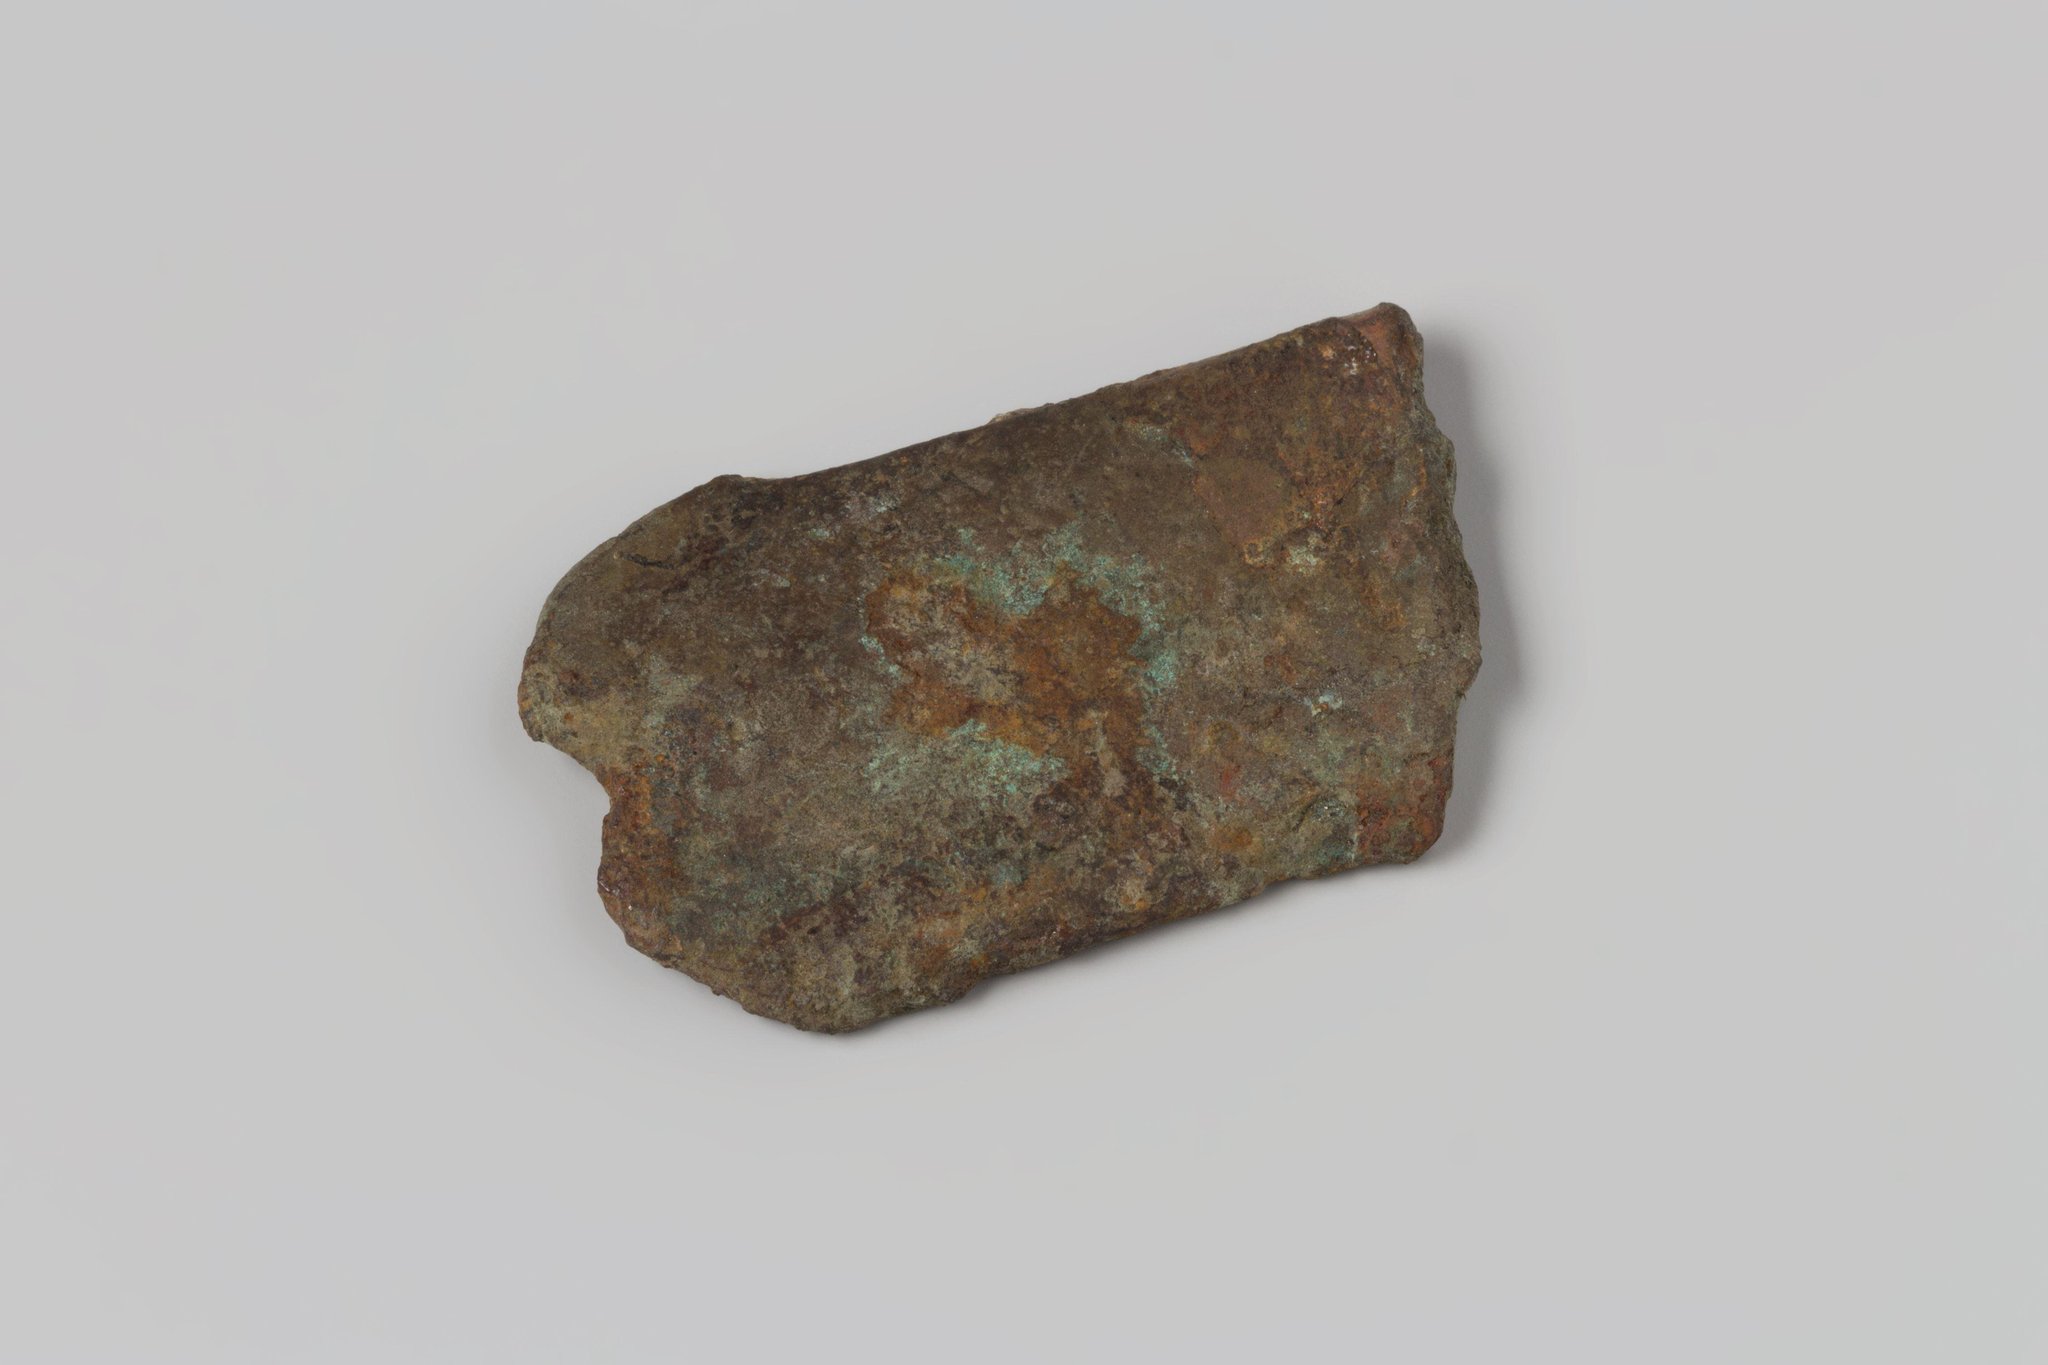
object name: scheepswrakvondst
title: Fragment van koper uit het wrak van de Oost-Indiëvaarder Hollandia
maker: Anonymous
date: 1700-1743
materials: copper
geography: netherlands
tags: verenigde oostindische compagnie, hollandia (schip), annet